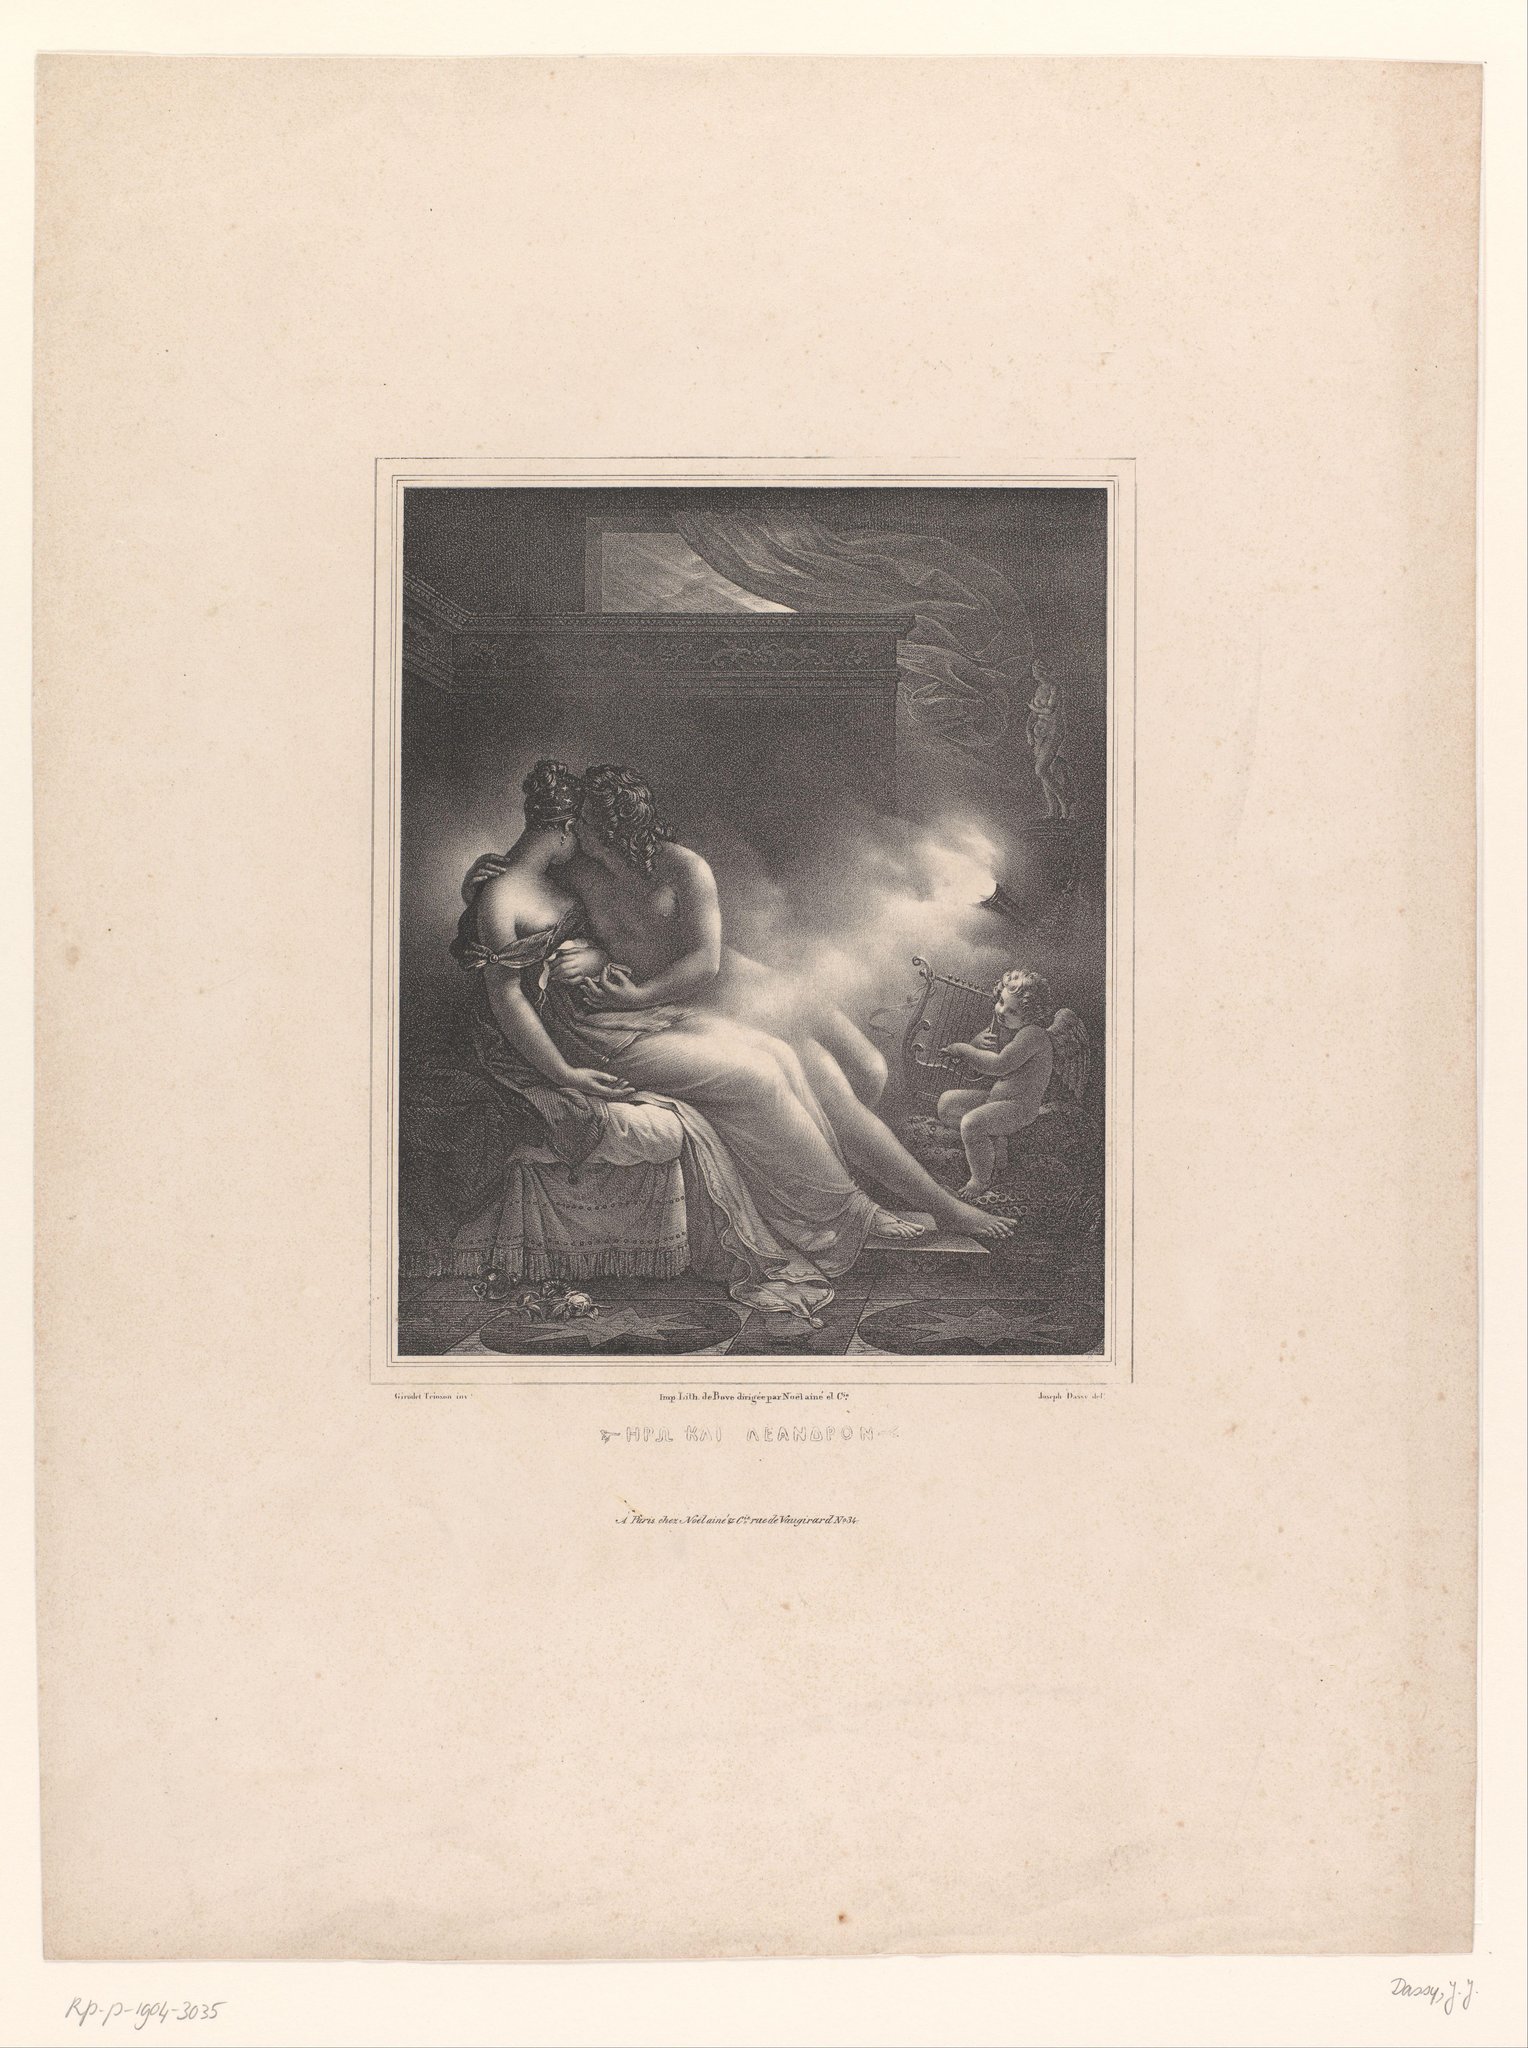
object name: print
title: Hero en Leander omhelzen elkaar in het licht van de fakkel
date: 1824-1840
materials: paper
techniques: lithograph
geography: paris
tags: torch, (lovers) embracing each other, 'symplegma', (story of) hero and leander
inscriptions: collector's mark: Lugt 2228a